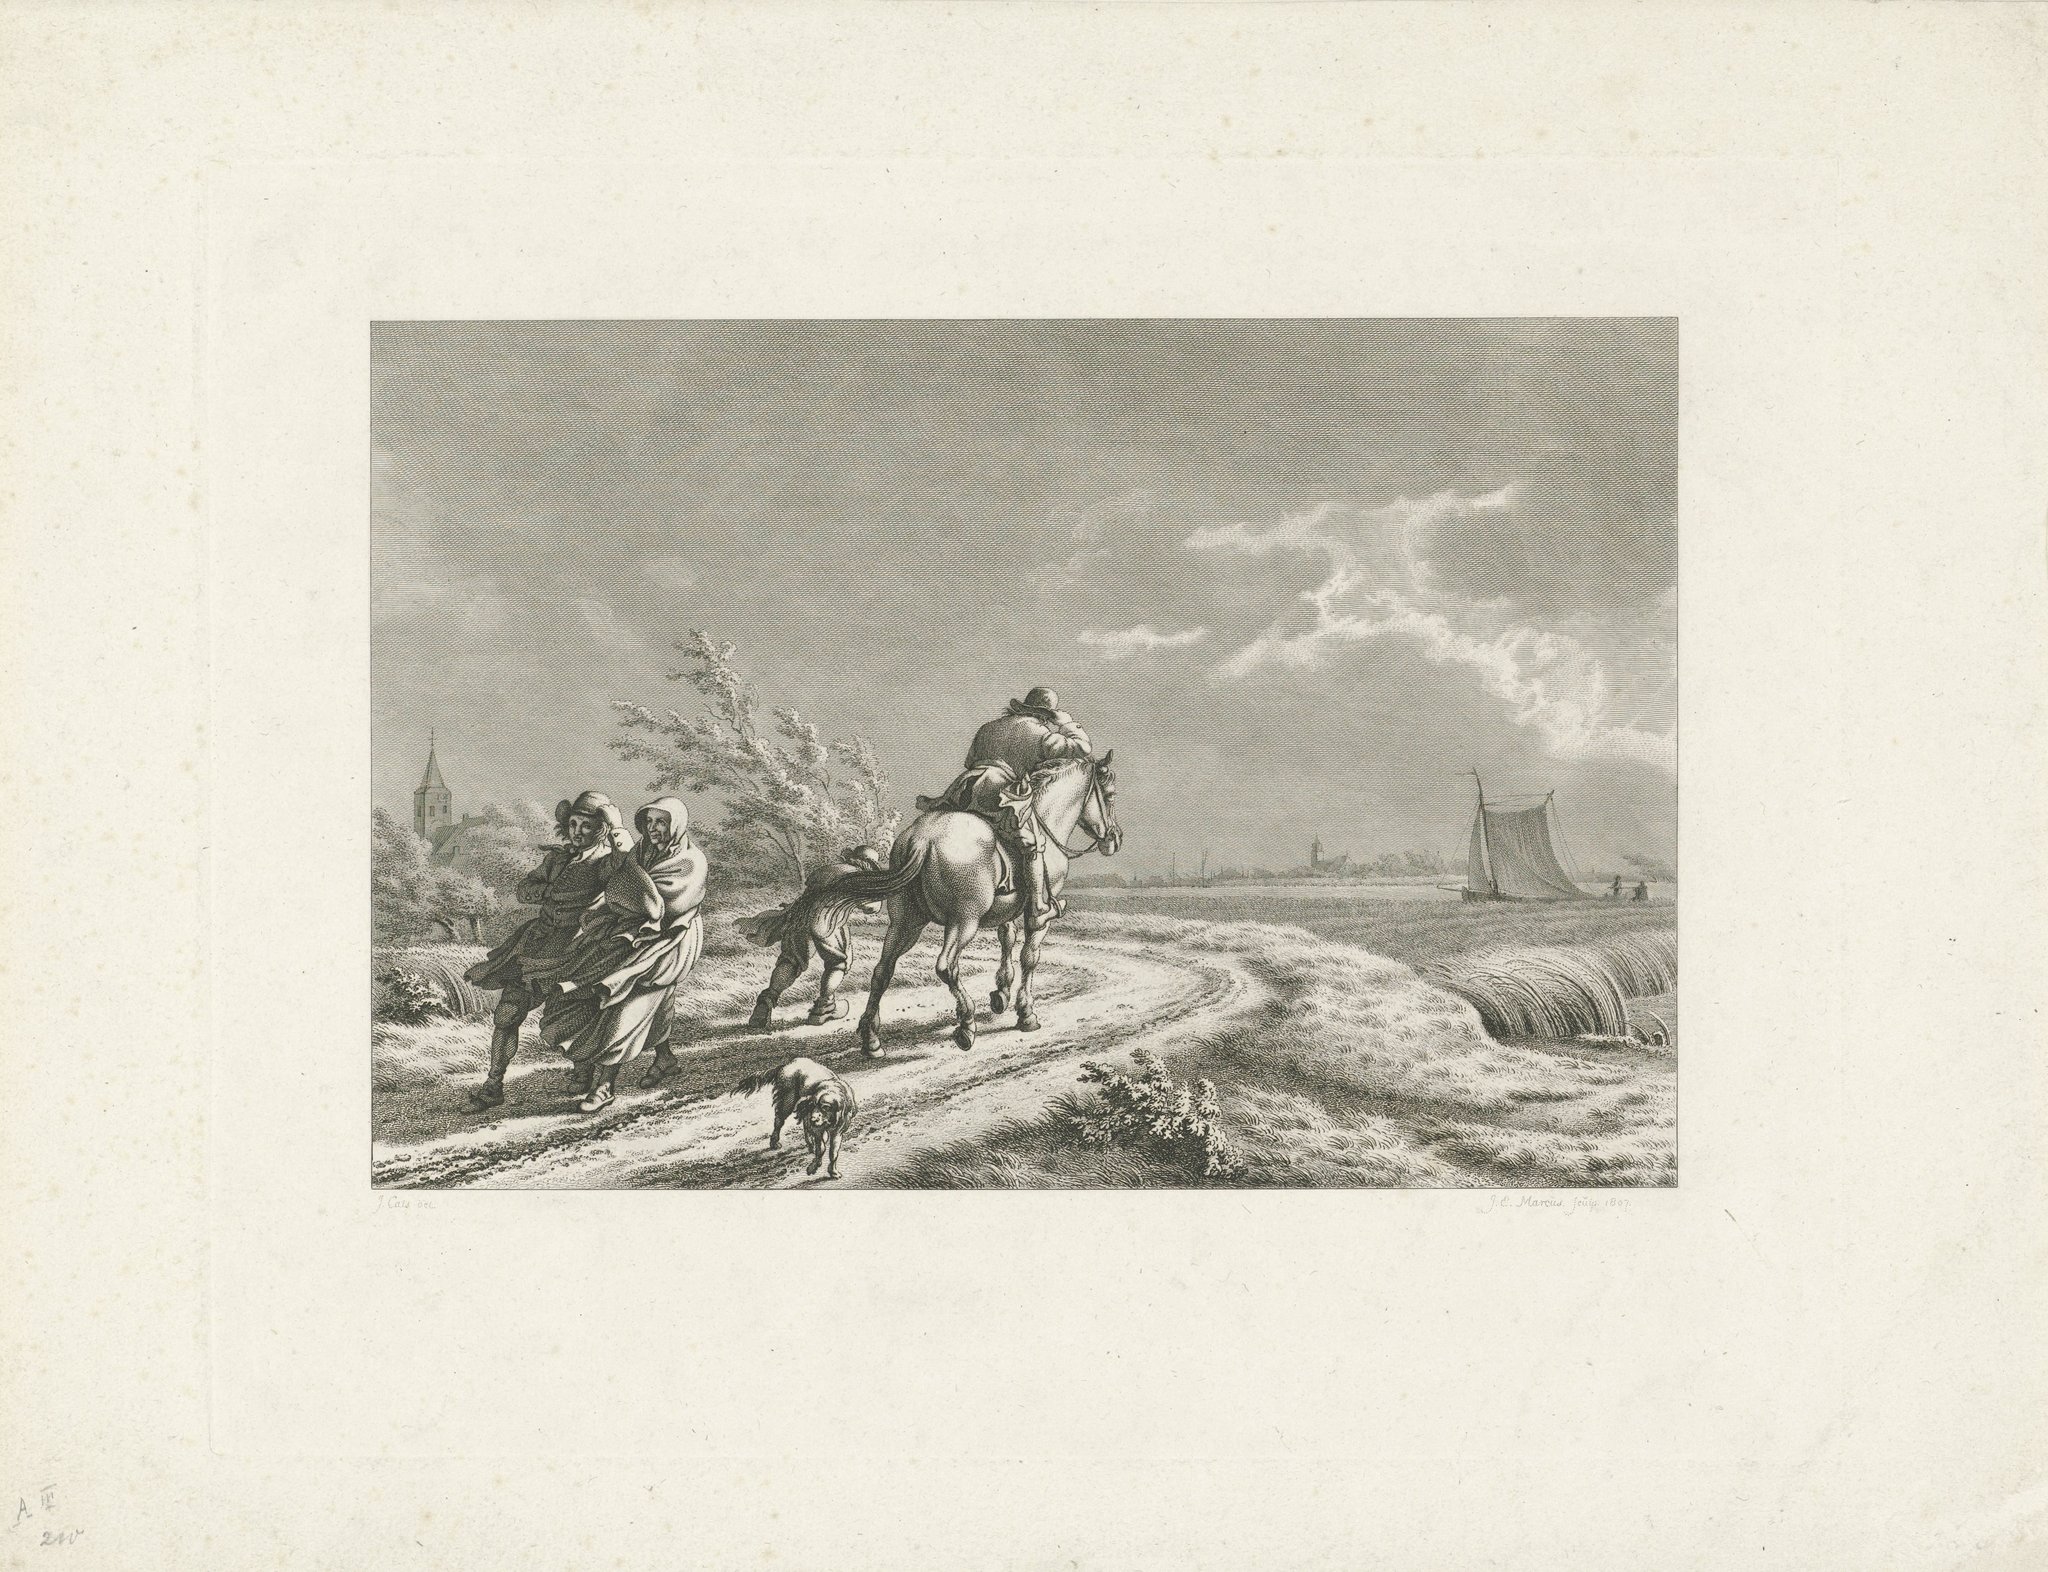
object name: print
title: Landschap bij stormachtig weer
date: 1807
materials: paper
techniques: etching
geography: amsterdam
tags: riding a horse, ass, or mule; rider, horseman, storm, dog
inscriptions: collector's mark: Lugt 2228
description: Een paar met een hond en een man op een paard met naast hem een tweede figuur op een dijkje in een polderlandschap bij stormachtig weer.